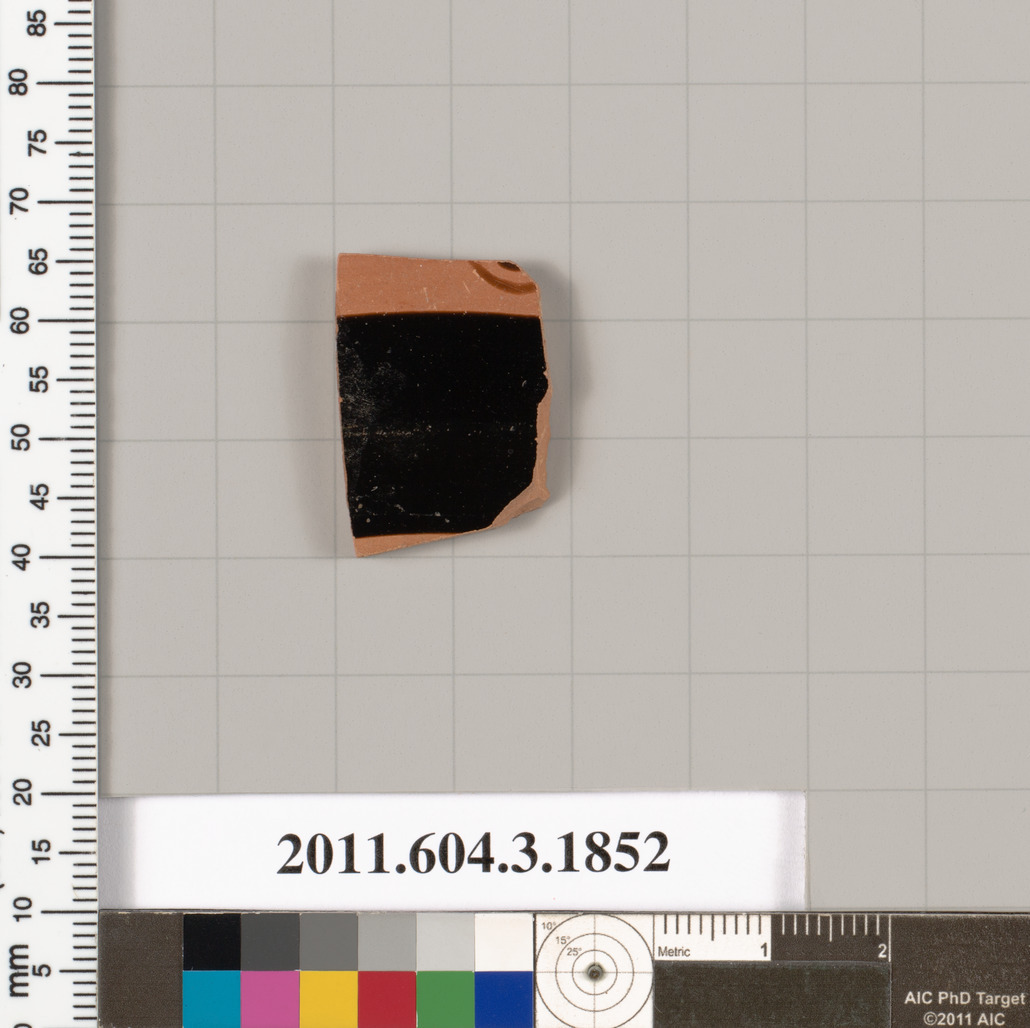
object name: kylix fragment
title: Terracotta fragment of a kylix: Lip cup (drinking cup)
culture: greek, attic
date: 550-526 BCE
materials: terracotta